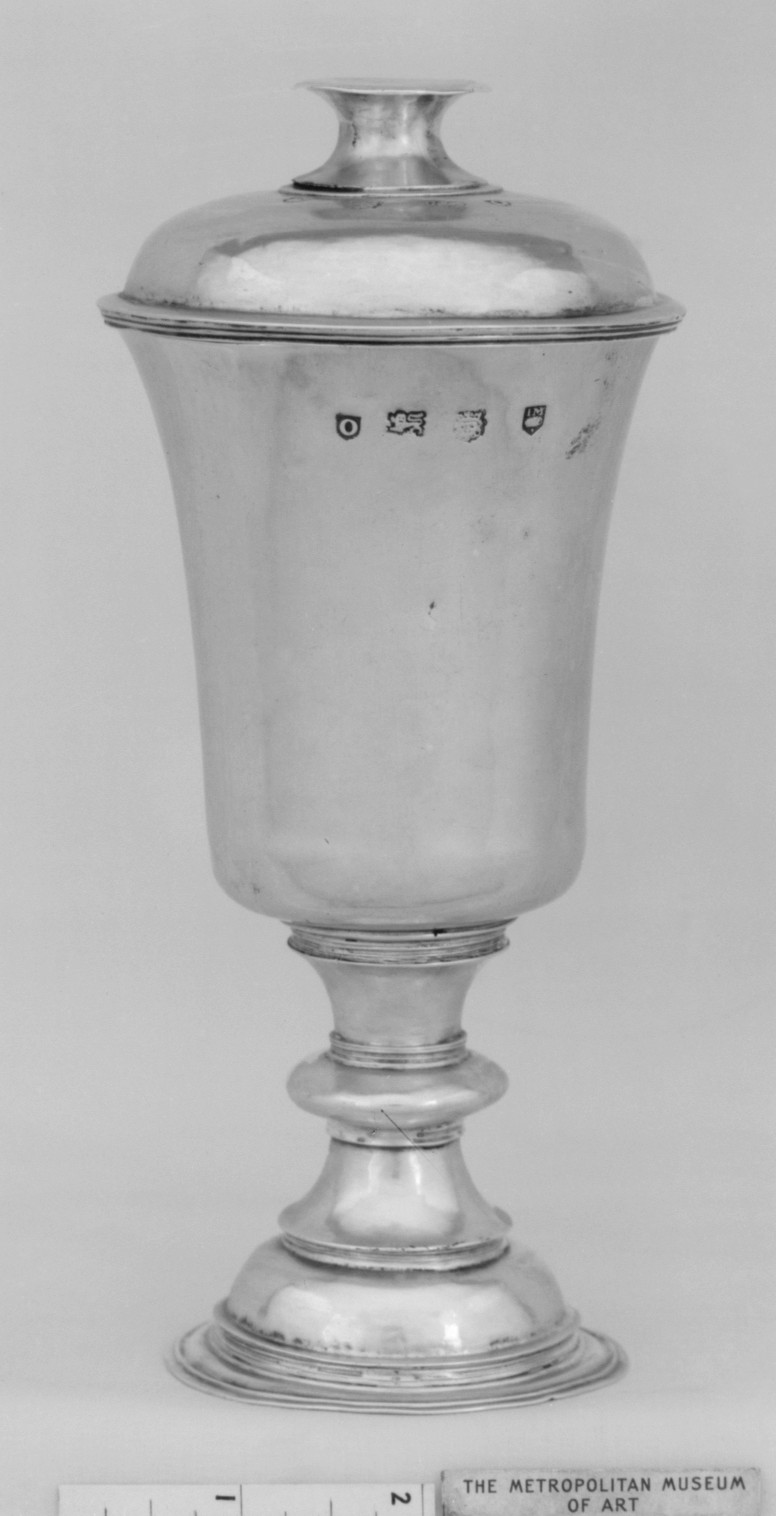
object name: communion cup and paten cover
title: Communion cup with paten cover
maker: john morley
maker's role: maker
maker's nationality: british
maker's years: 1550-1650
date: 1591-1592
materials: silver